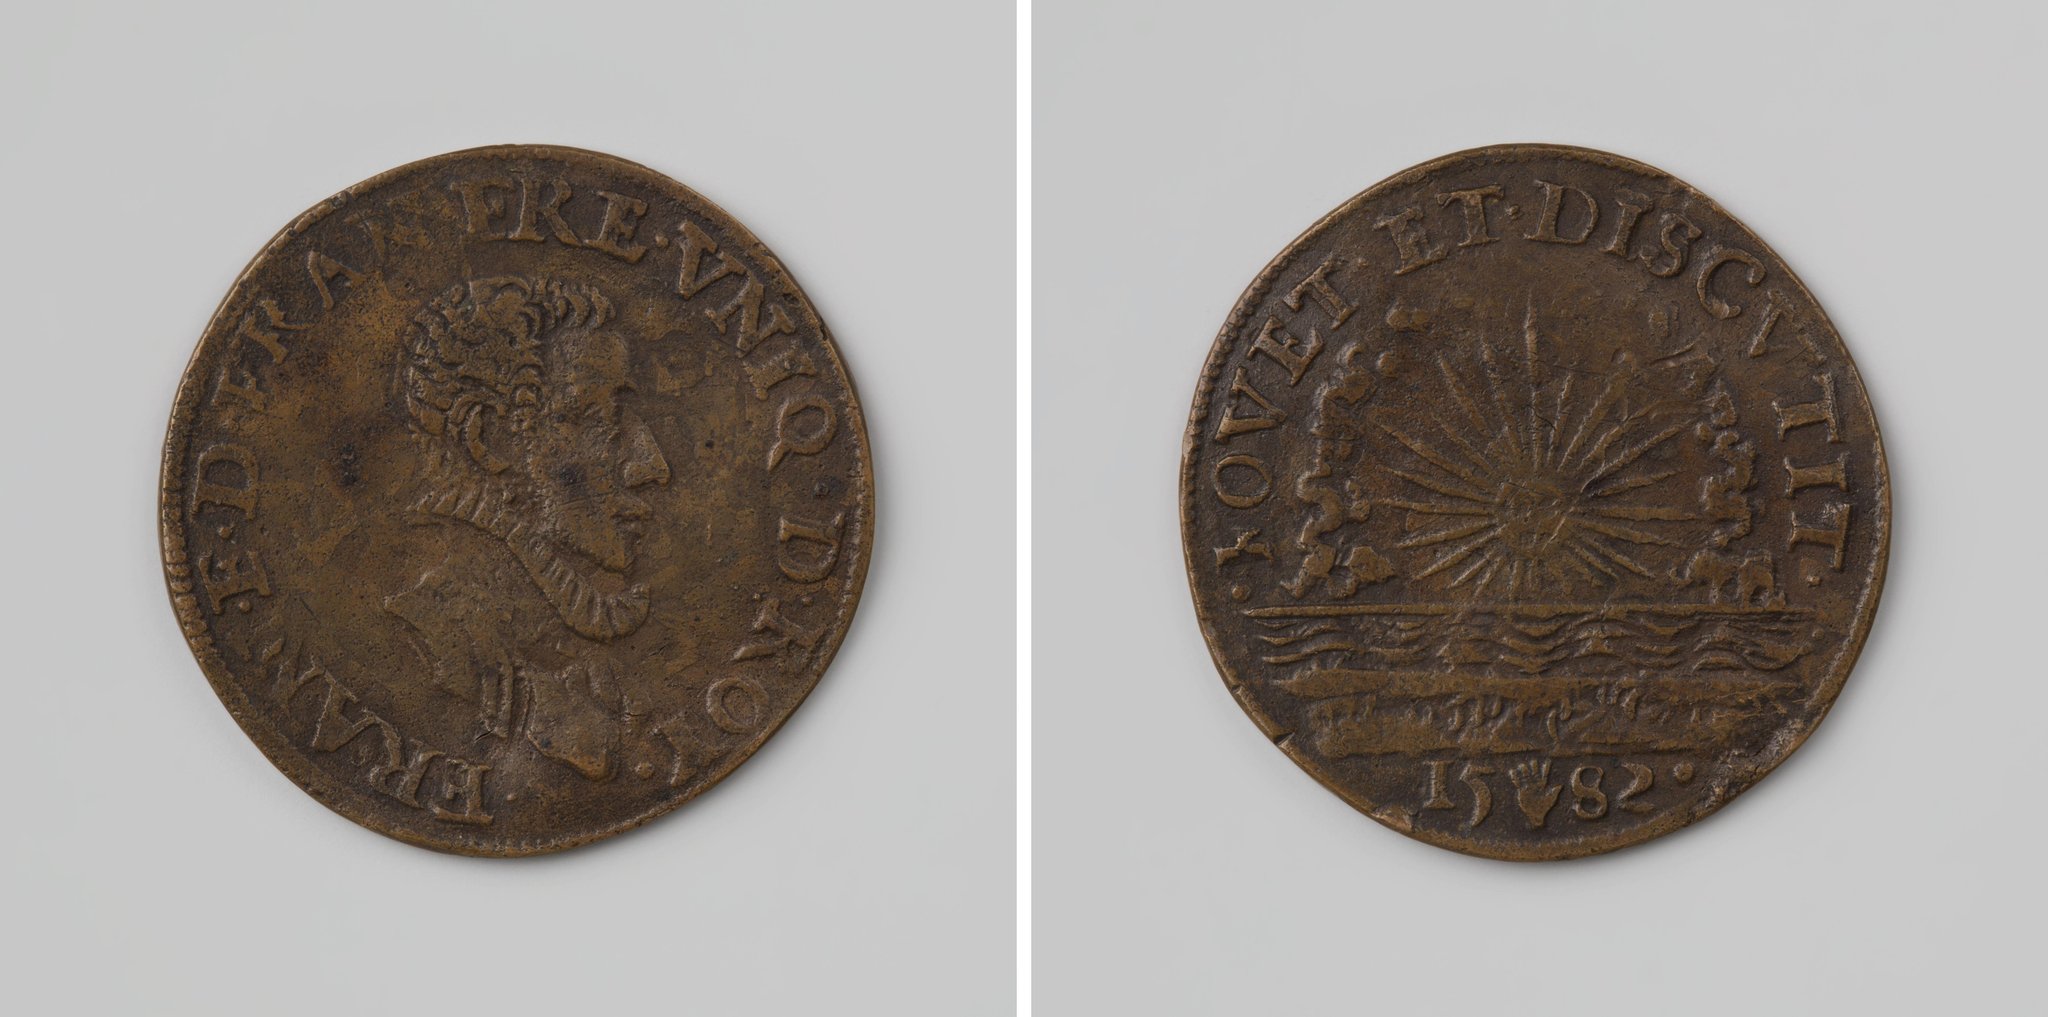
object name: jeton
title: Inhuldiging van Francois-Hercule, hertog van Anjou als hertog van Brabant te Antwerpen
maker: Anonymous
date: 1582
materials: copper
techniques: striking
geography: antwerp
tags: françois-hercule de valois (hertog van anjou), antwerp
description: Koperen penning. Voorzijde: borststuk man binnen omschrift. Keerzijde: zon verdrijft wolken boven zee binnen omschrift, boven jaartal